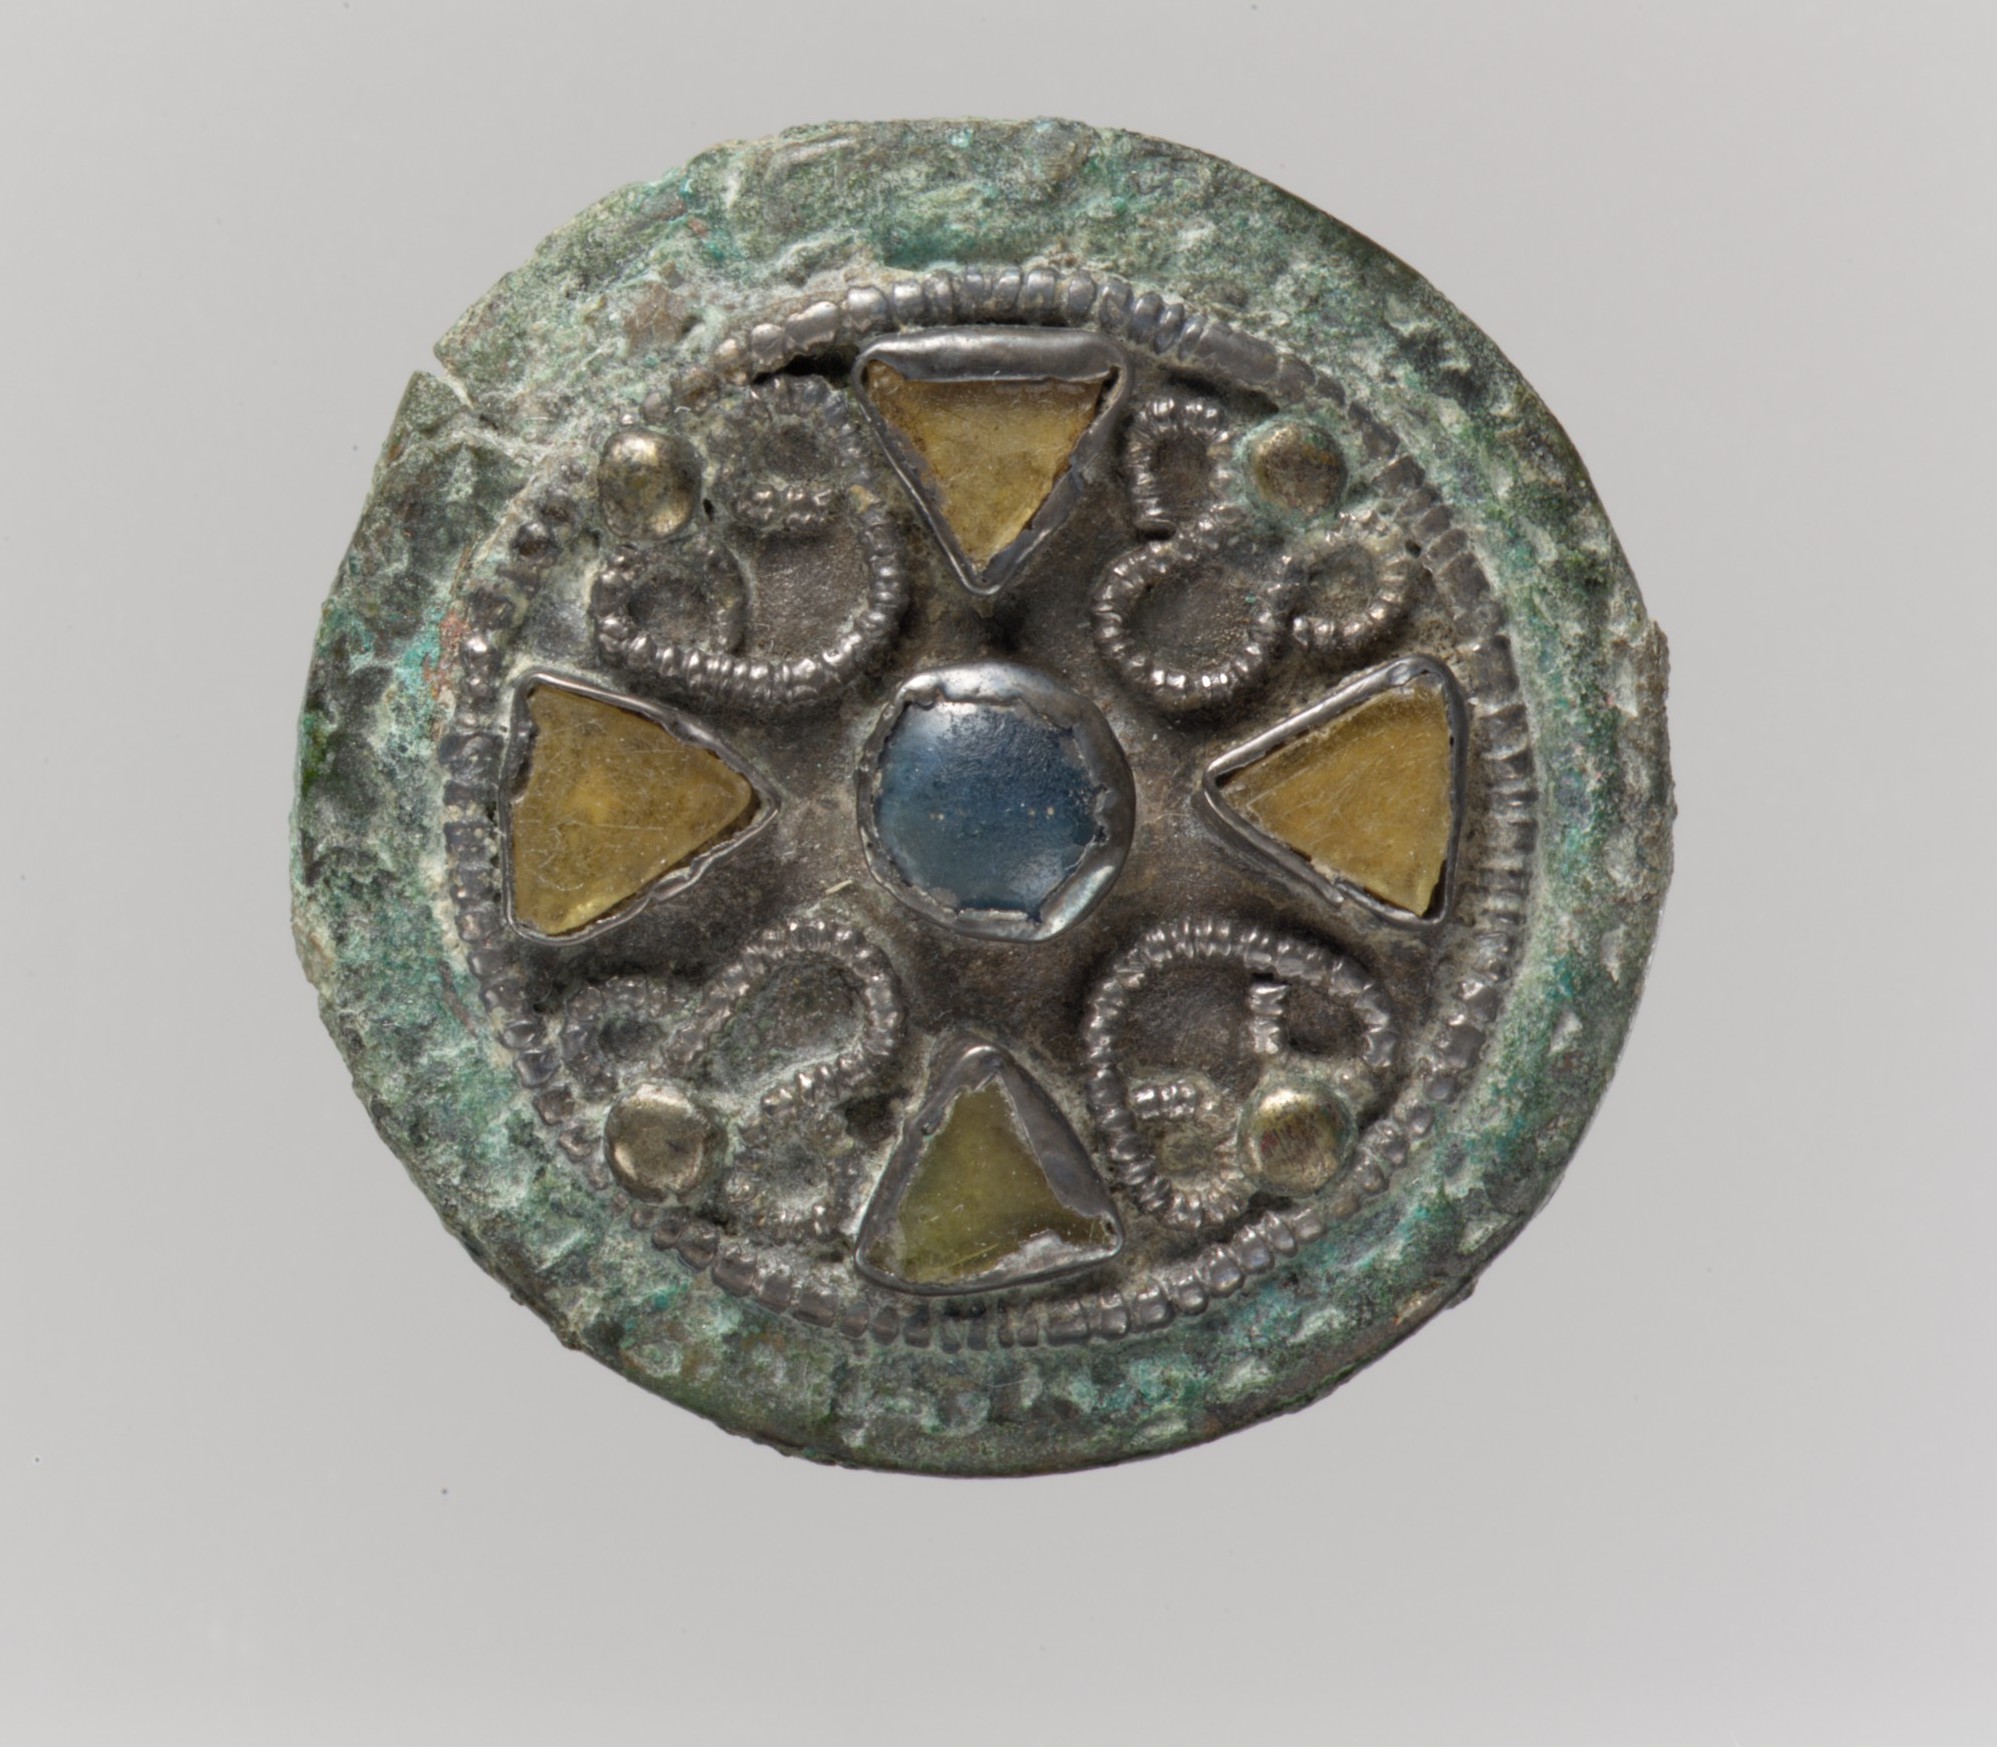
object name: brooch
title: Disk Brooch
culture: frankish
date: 501-700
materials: amber, copper alloy, glass, silver gilt